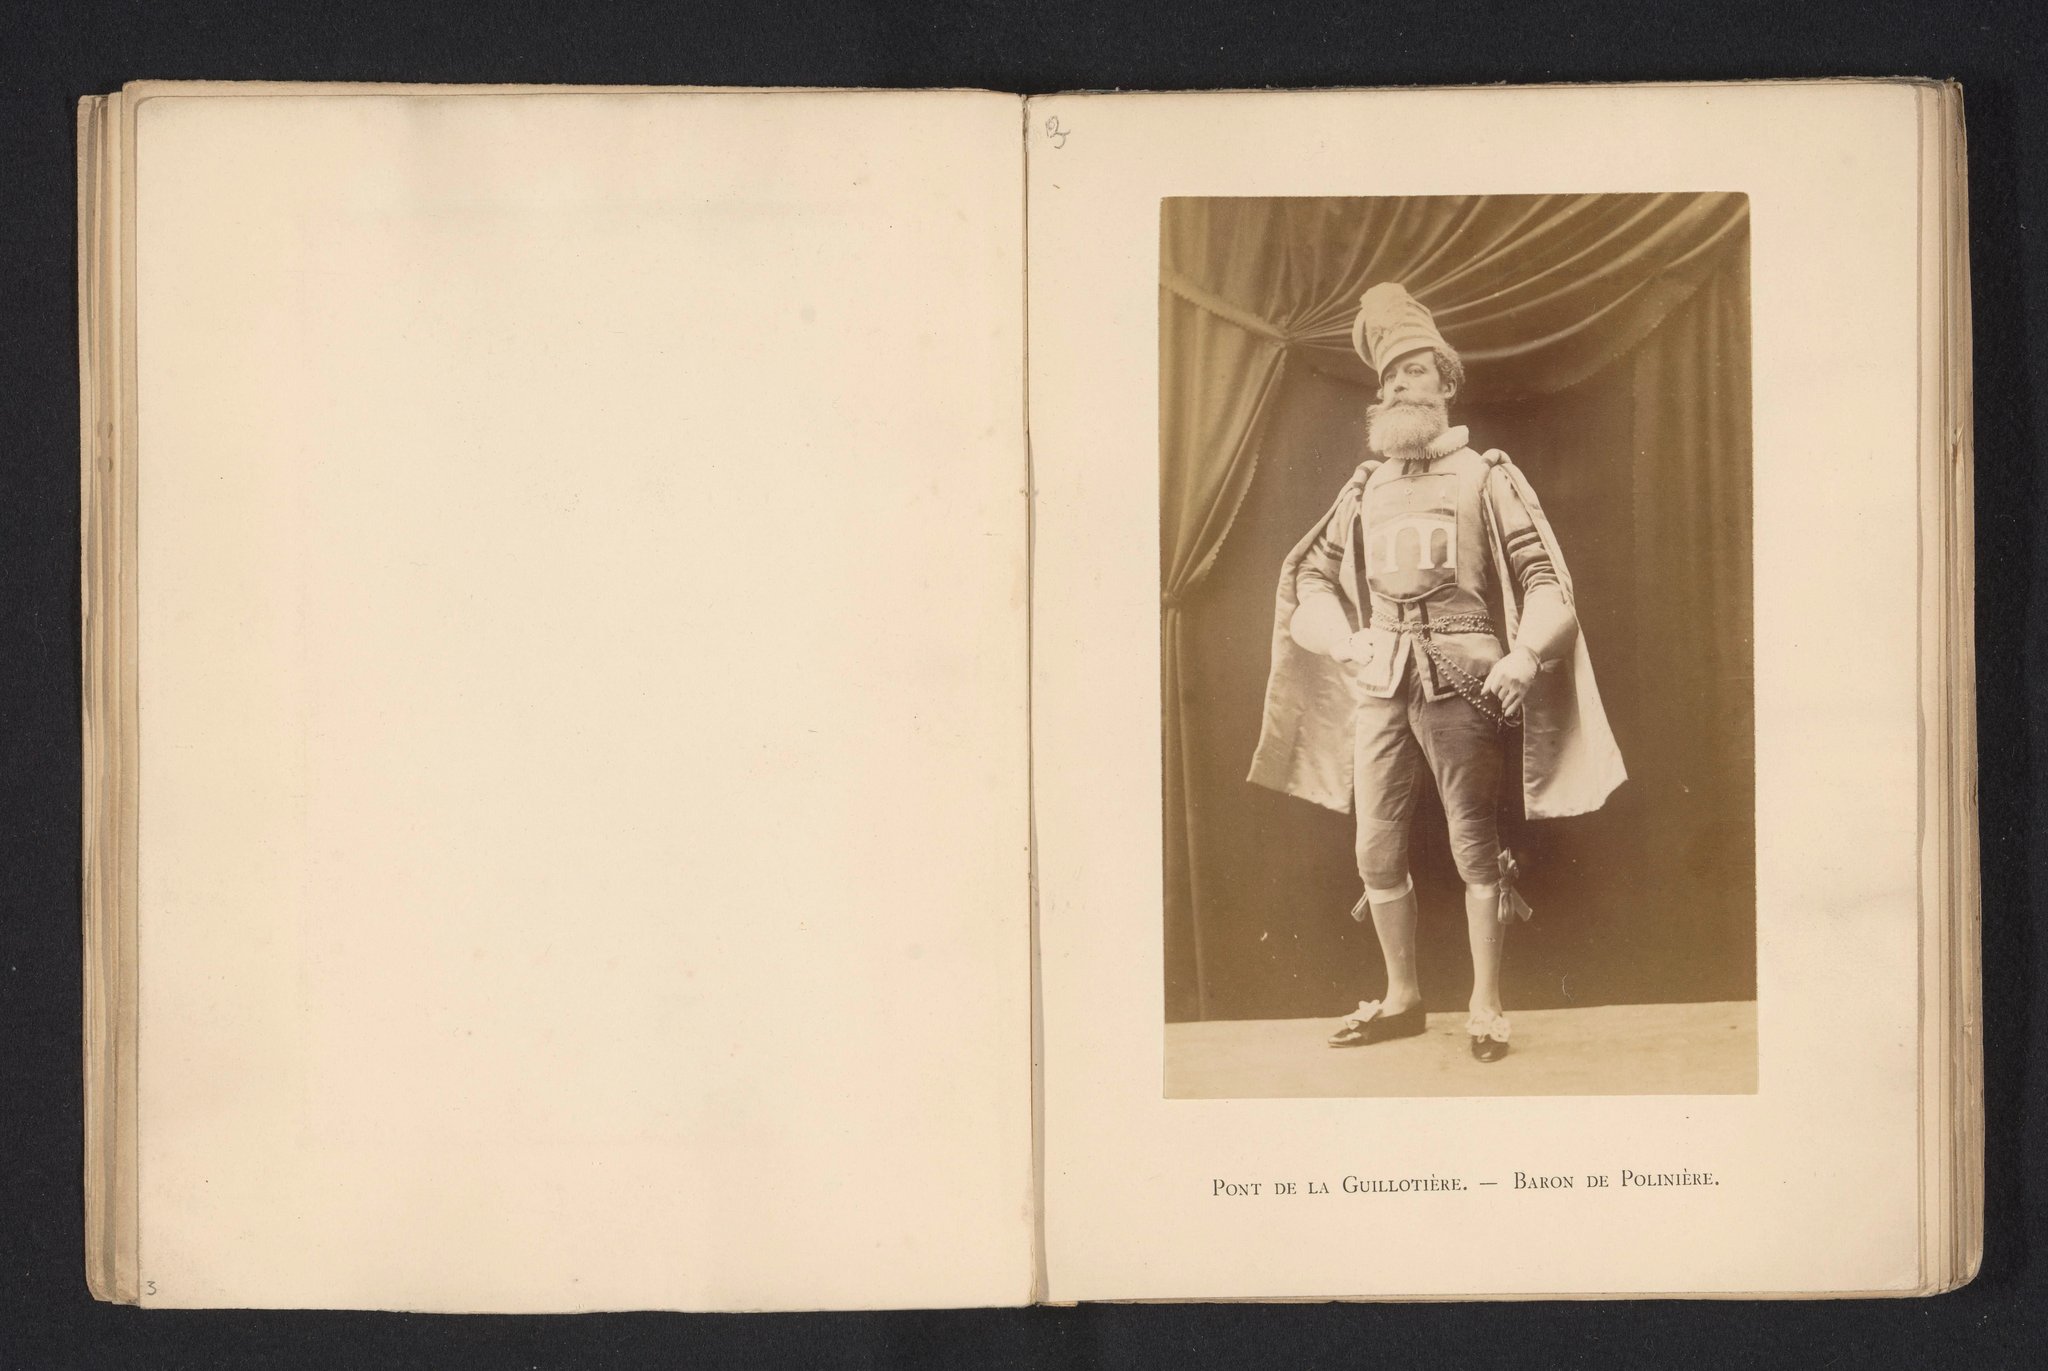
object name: photograph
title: Portret van Baron de Polinière verkleed als de Pont de la Guillotière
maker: Anonymous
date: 1803-1891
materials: photographic support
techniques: albumen print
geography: lyon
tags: actor (on the stage)